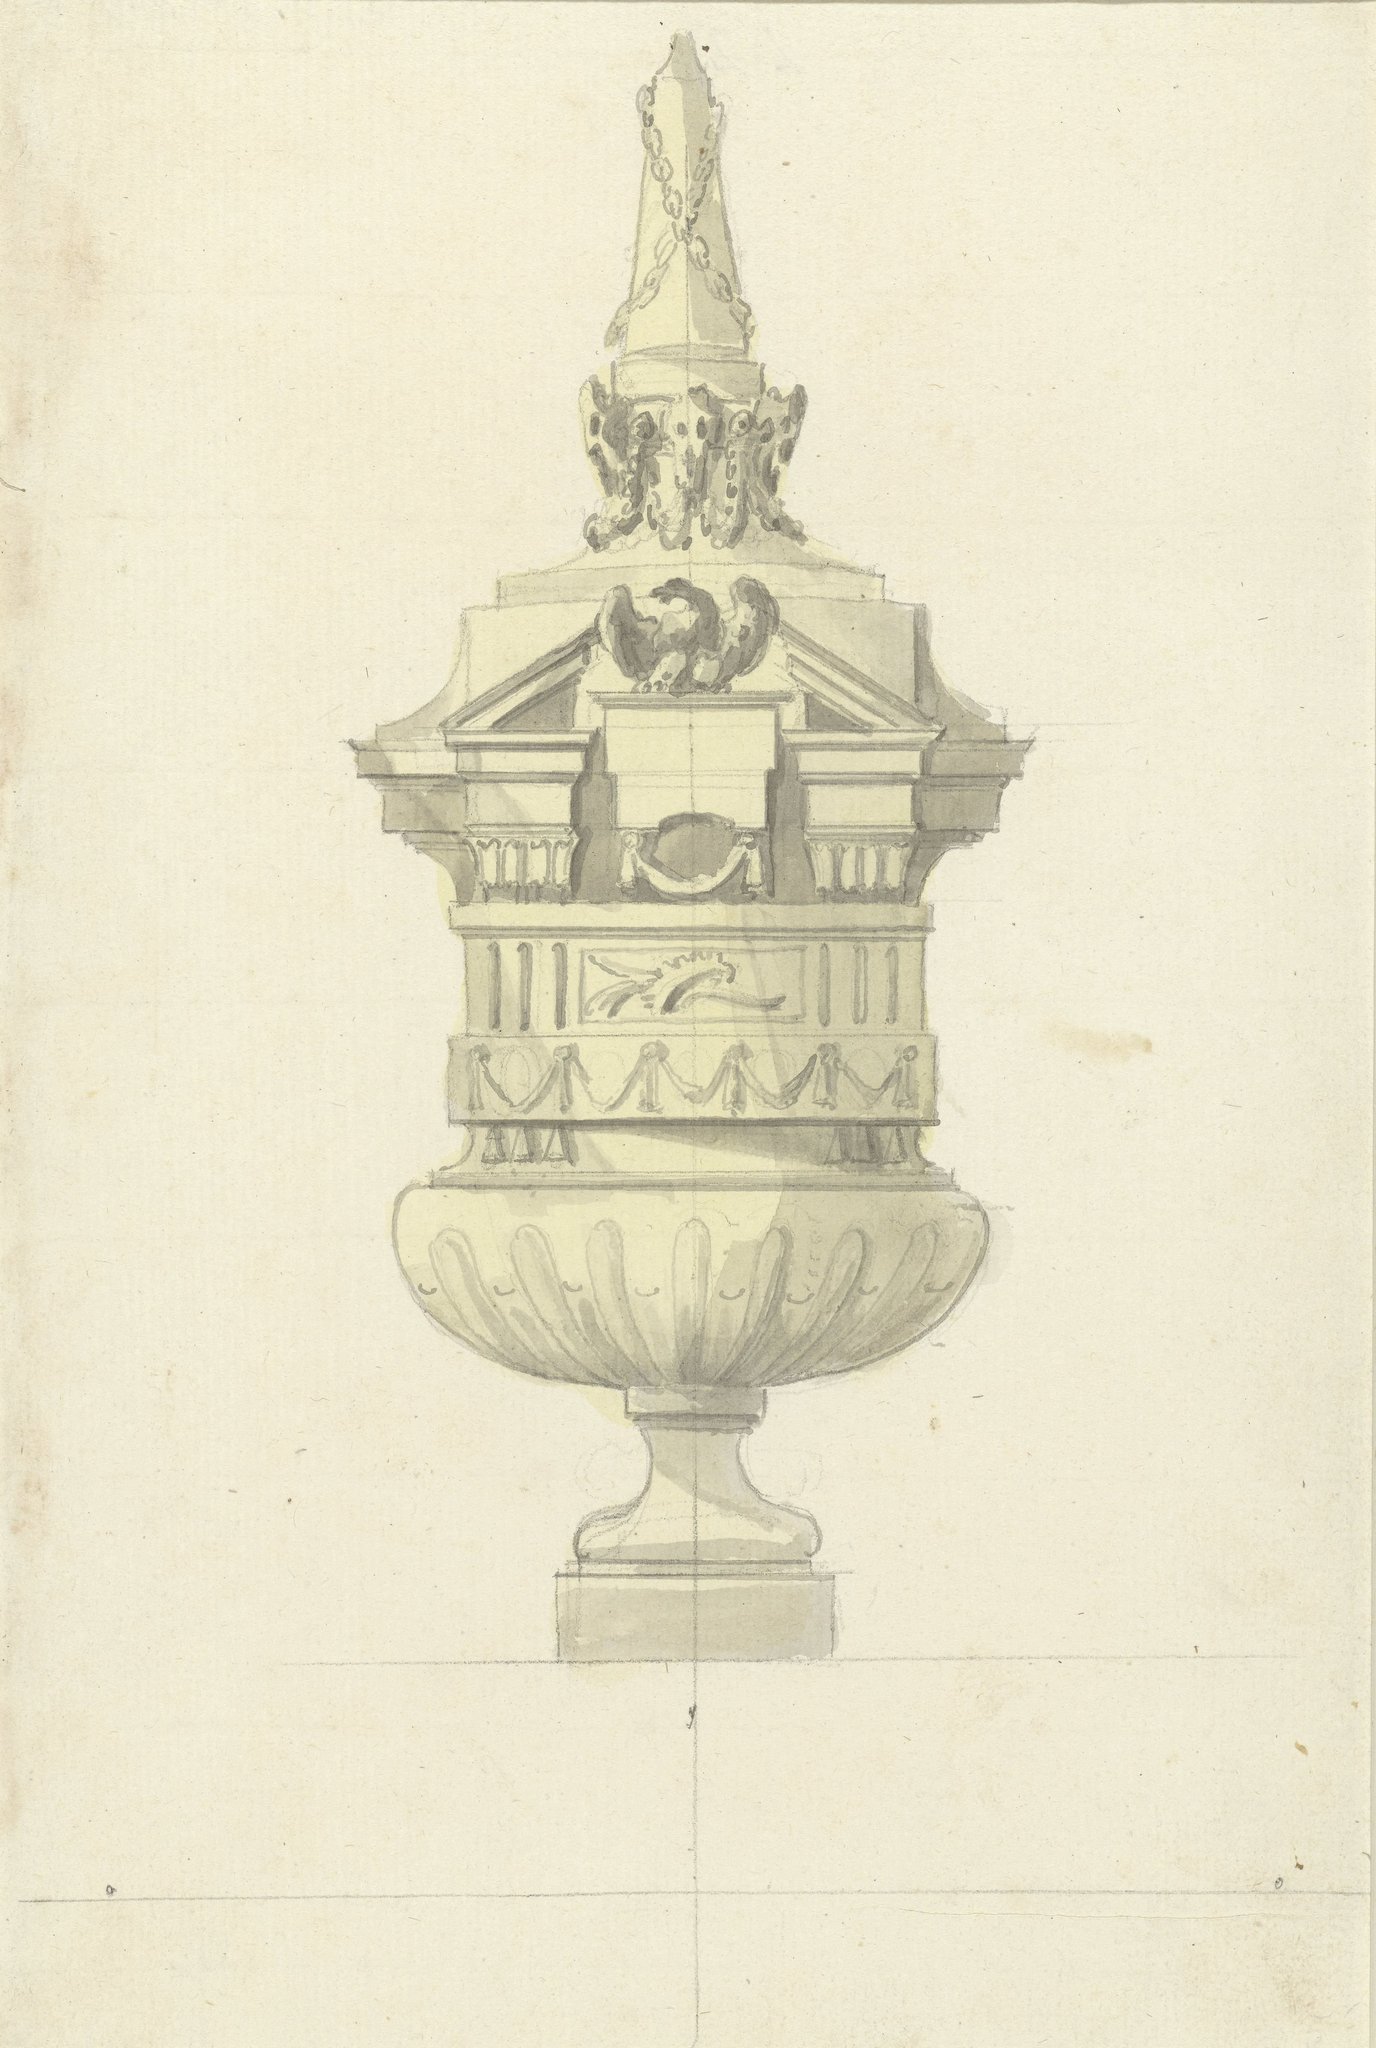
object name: drawing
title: Siervaas bekroond met een gebroken timpaan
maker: Anonymous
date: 1700-1800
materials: paper, pencil, watercolor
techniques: brush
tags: containers, garden vase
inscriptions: collector's mark, verso, on the passepartout, lower right: Lugt 2228, inscription, verso, upper centre, pen and brown ink: ‘22.’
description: Siervaas, waarvan de bovenzijde als architectuur bekroond wordt met een gebroken timpaan, waarin een adelaar is opgesteld.